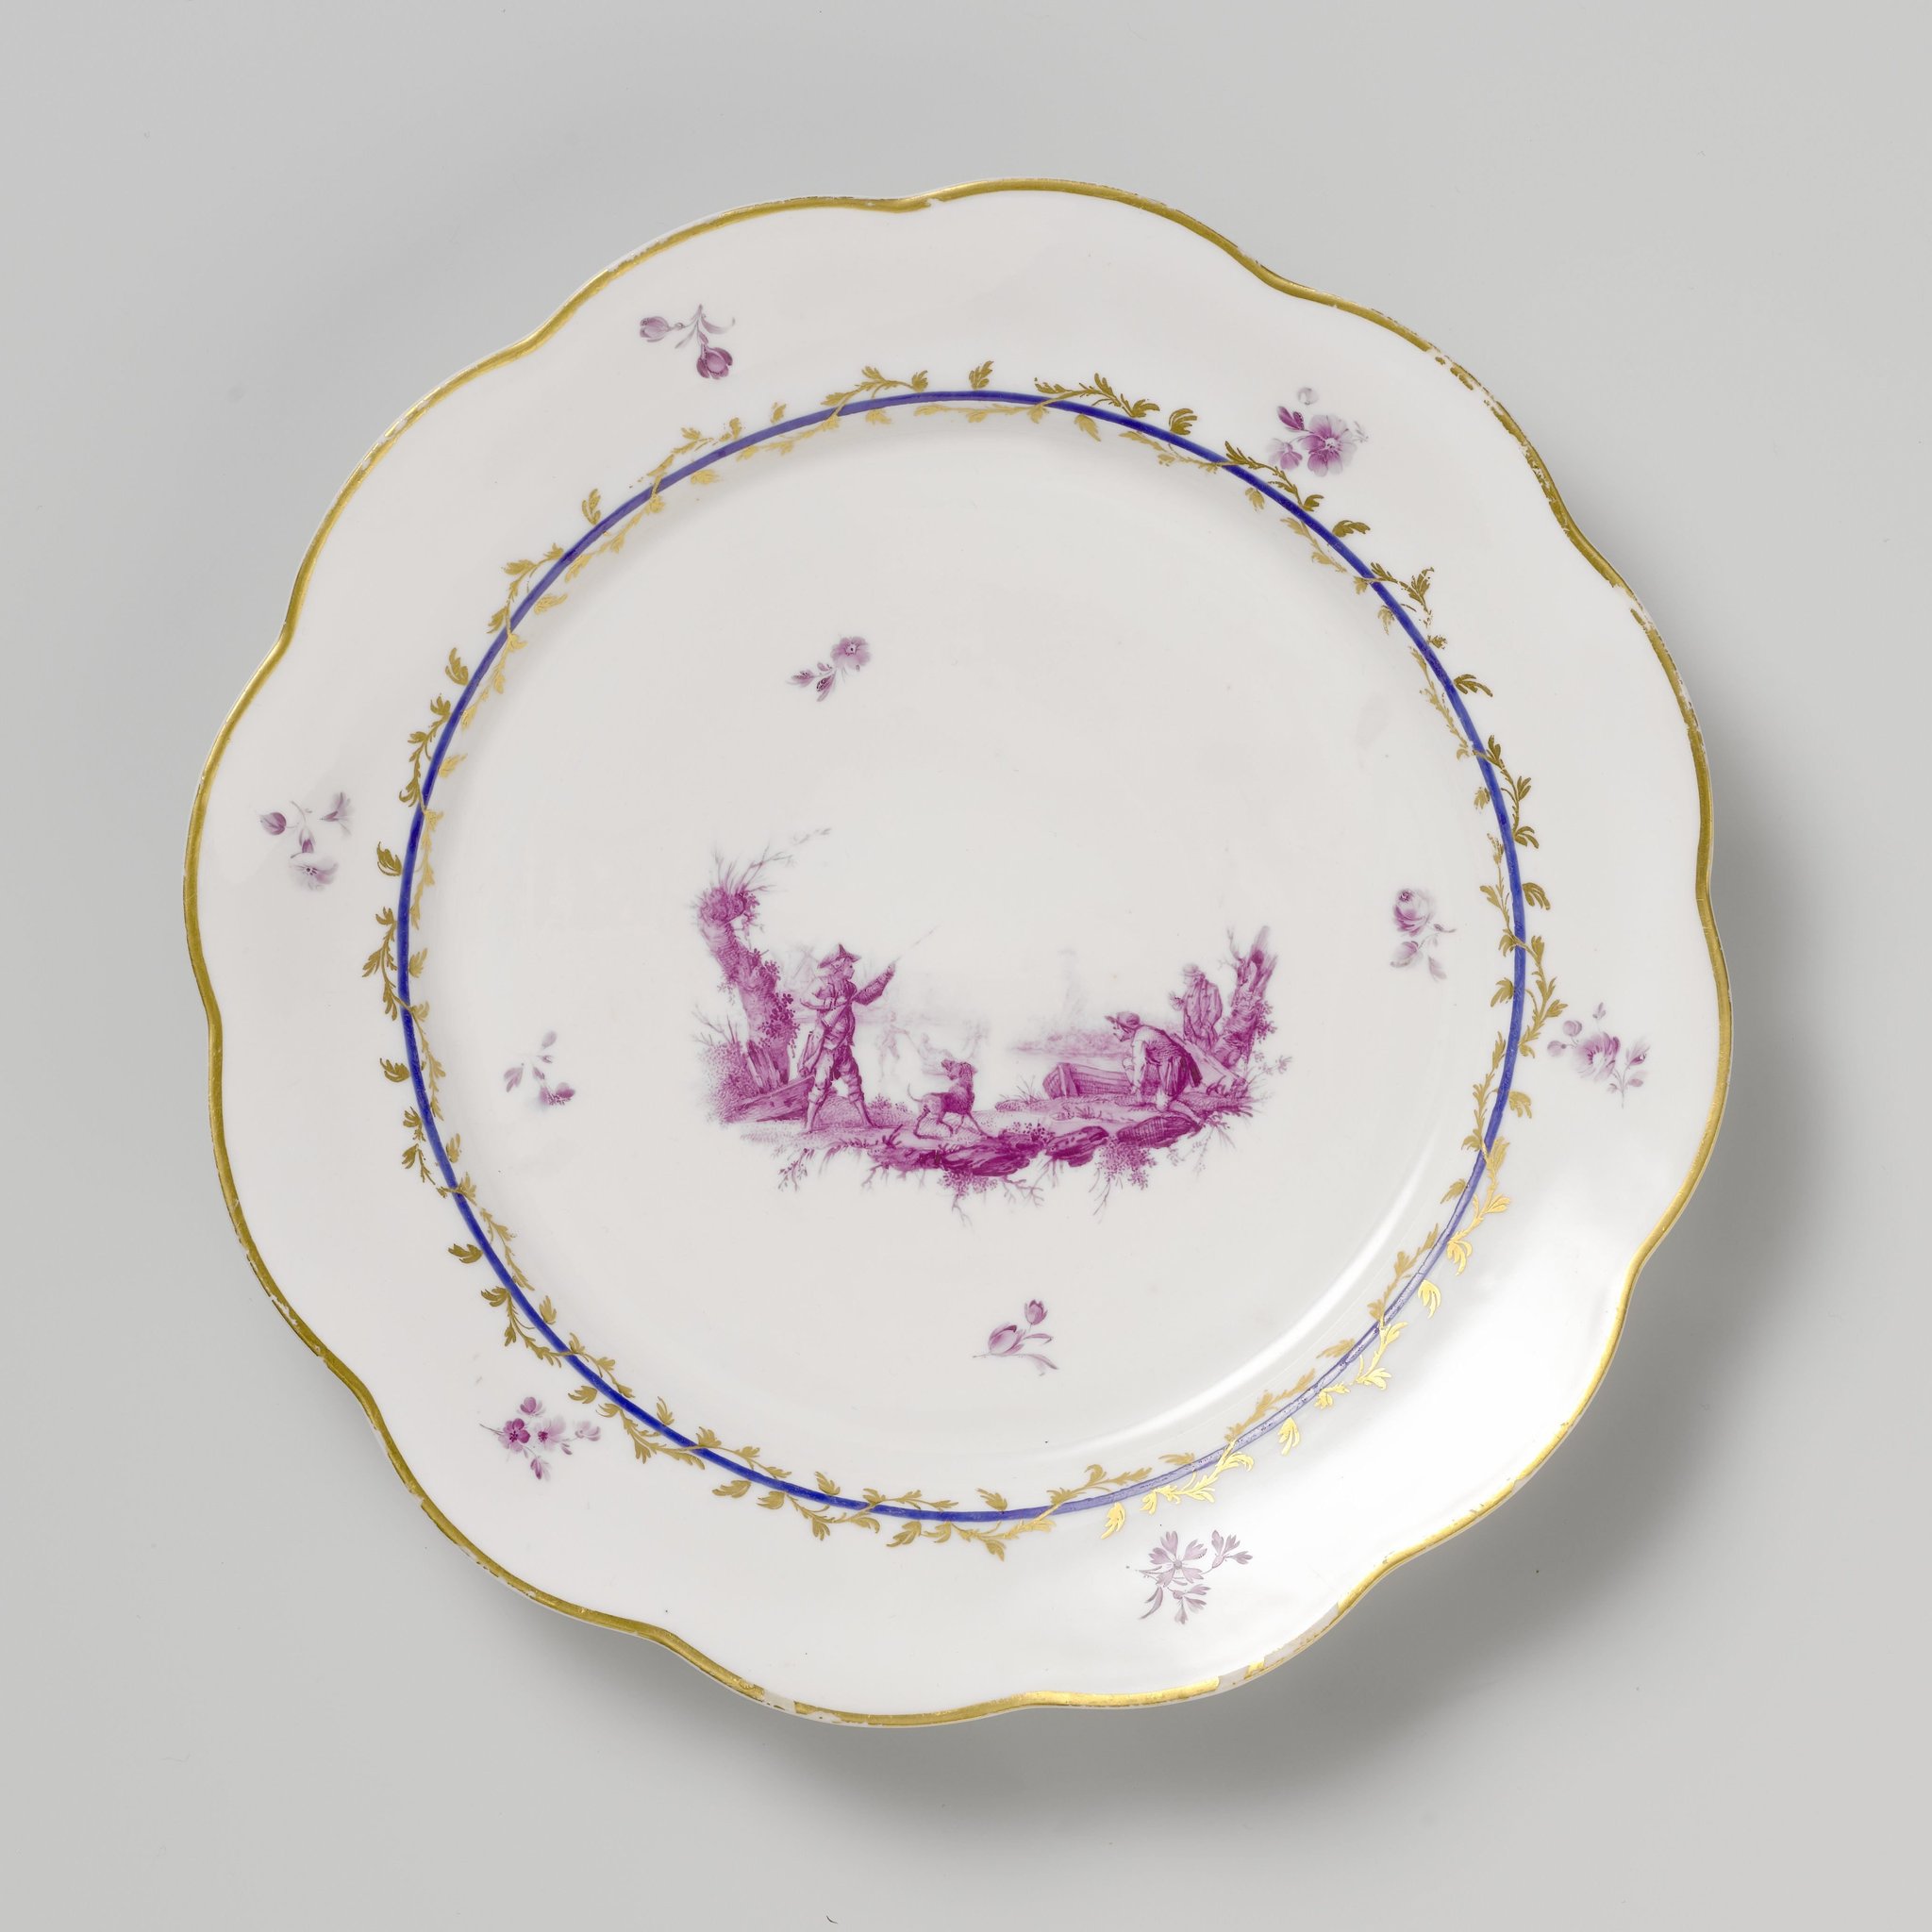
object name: plate dish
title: Plate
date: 1778-1782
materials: porcelain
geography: loosdrecht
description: Manufactuur Oud-Loosdrecht Loosdrecht, c. 1778–1782 hard-paste porcelain